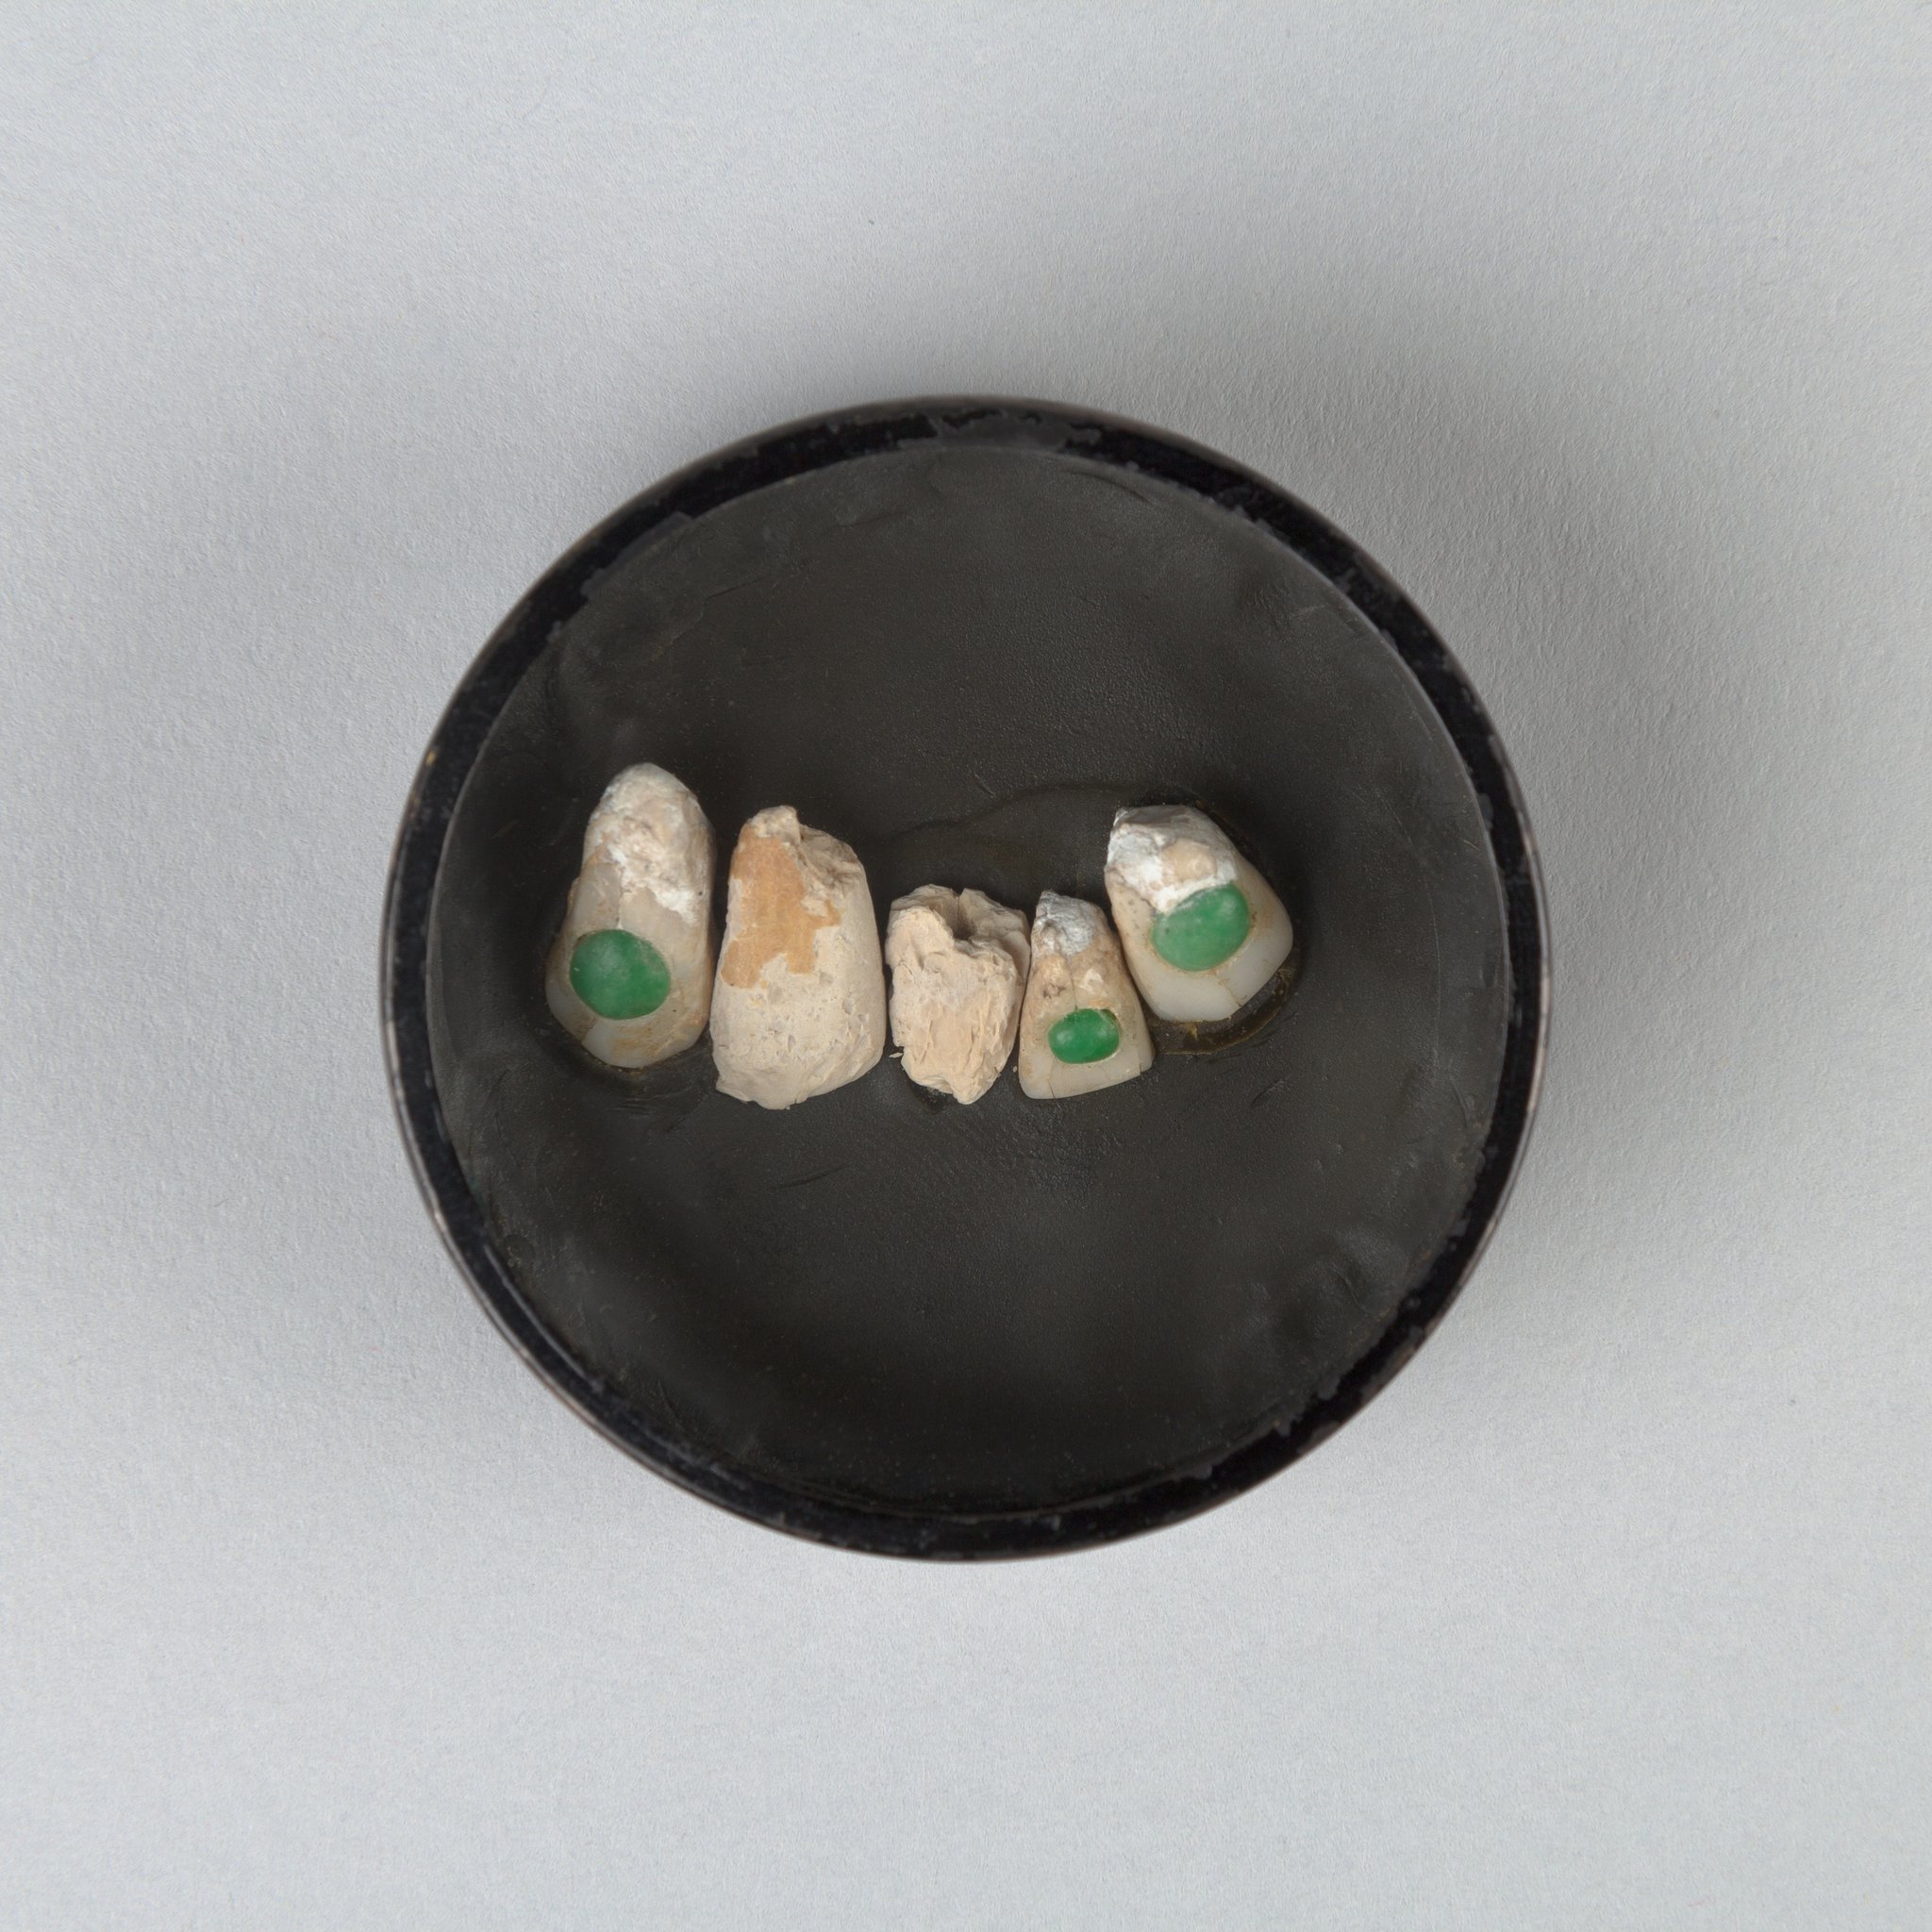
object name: human tooth inlaid with jadeite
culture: mexican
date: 1902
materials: jade